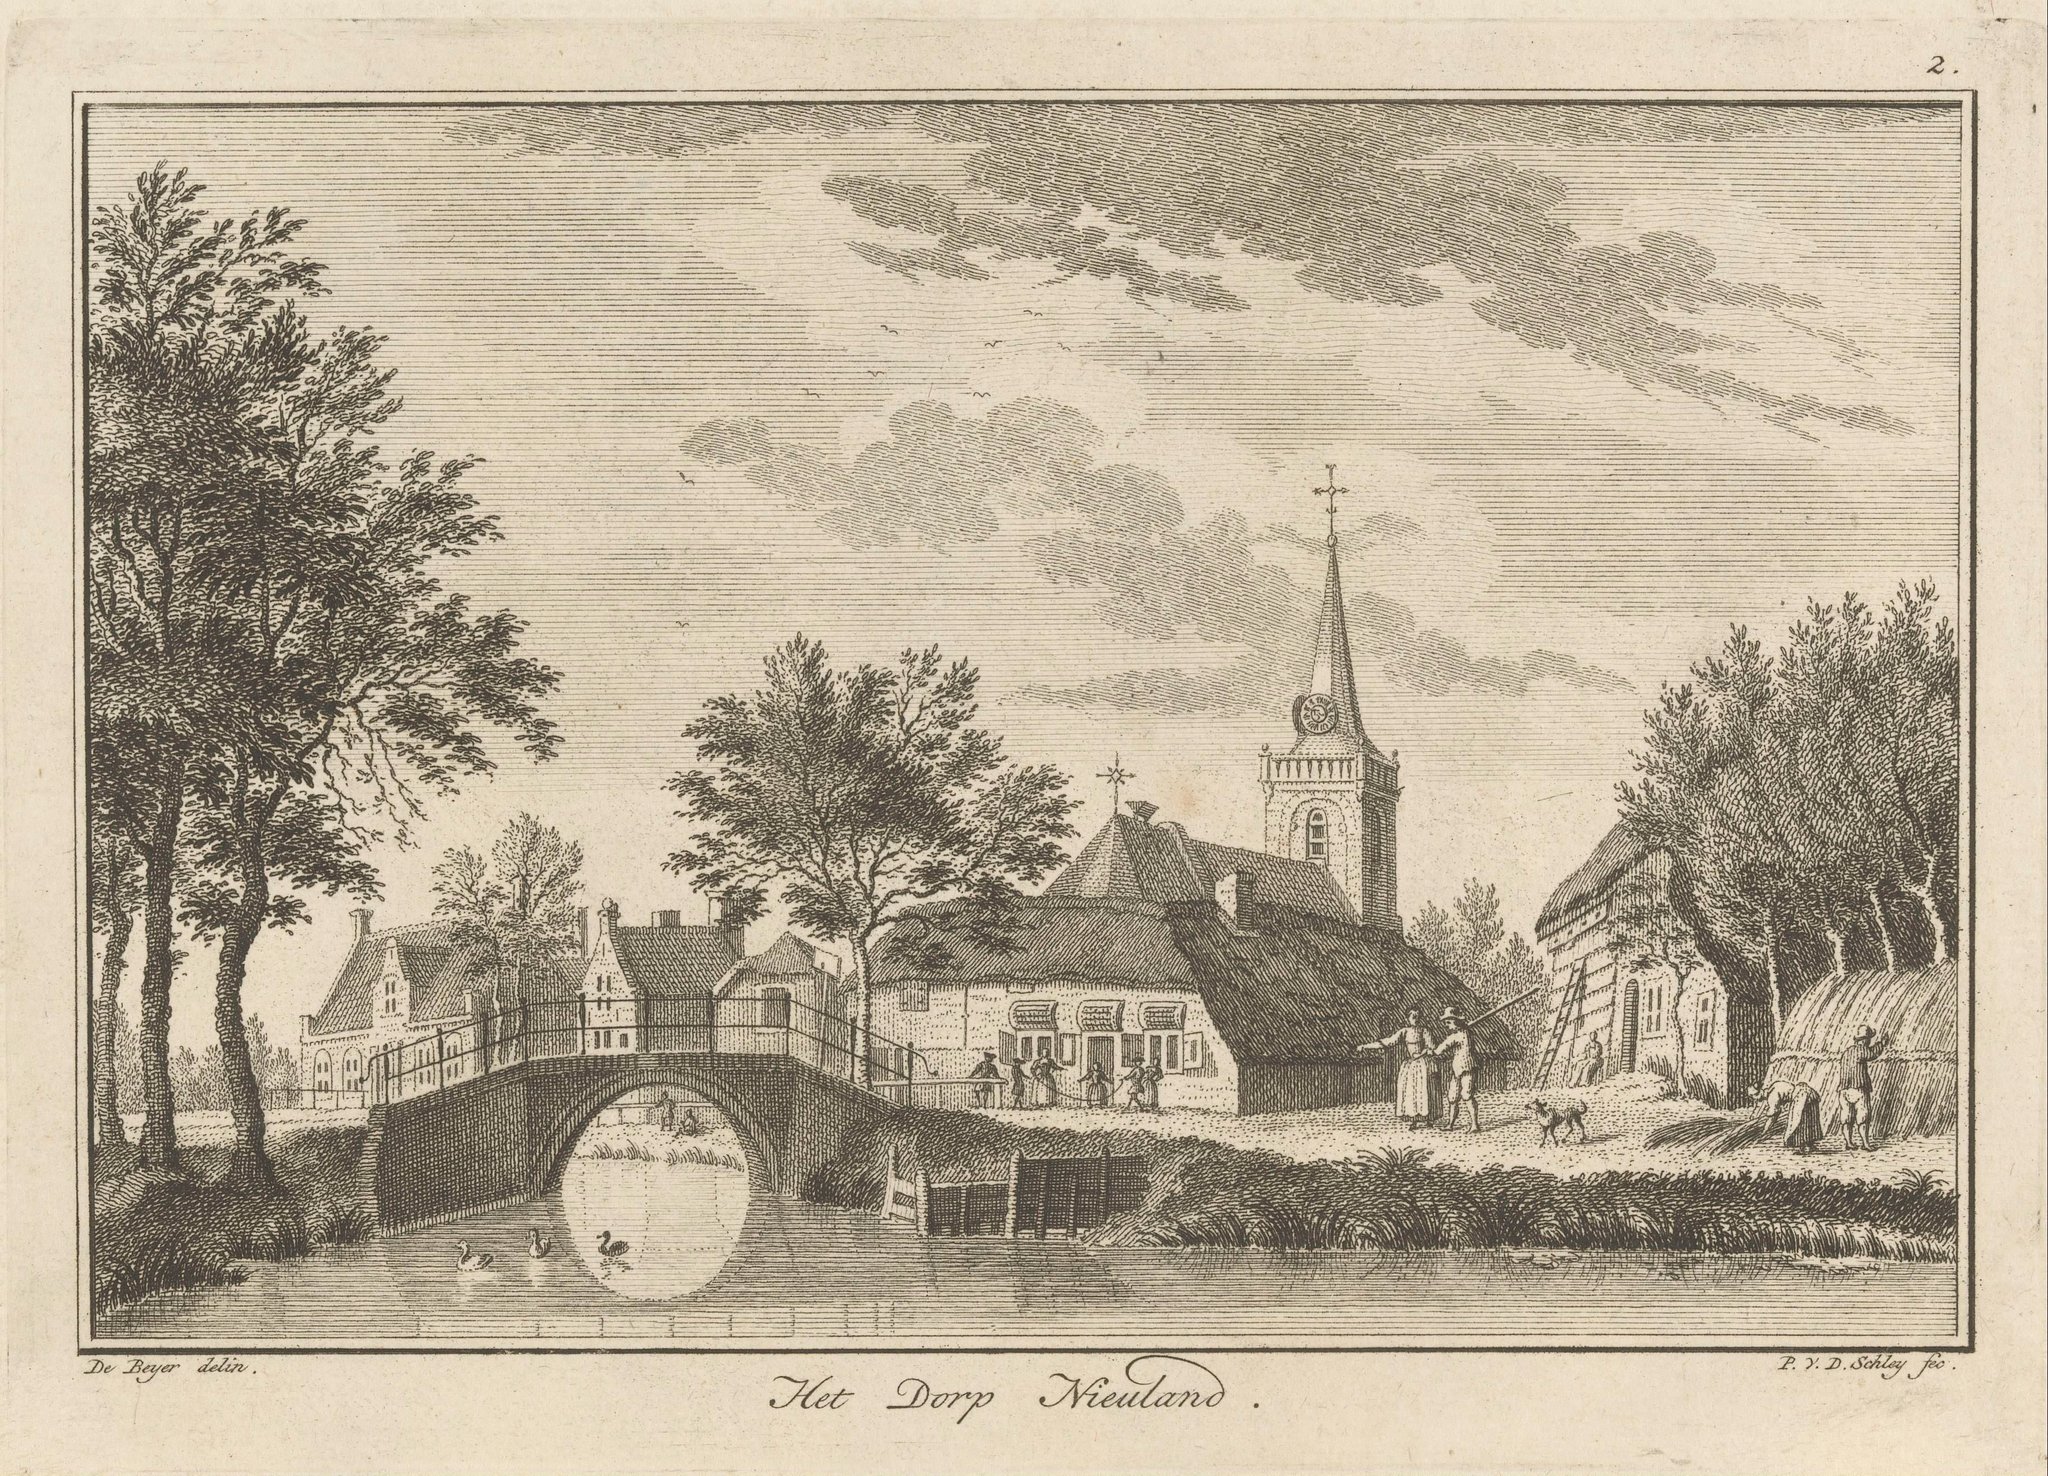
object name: print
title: Gezicht op het dorp Nieuwland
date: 1750-1817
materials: paper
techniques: etching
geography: amsterdam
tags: prospect of village, silhouette of village, church (exterior), jumping-rope games, bridge in village across river, canal, etc.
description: Gezicht op het dorp Nieuwland in de buurt van Gorinchem. Links een brug en rechts op de achtergrond de kerk. Bij het dorp bevinden zich verschillende figuren, waaronder touwtje springende kinderen. Rechtsboven genummerd: 2.